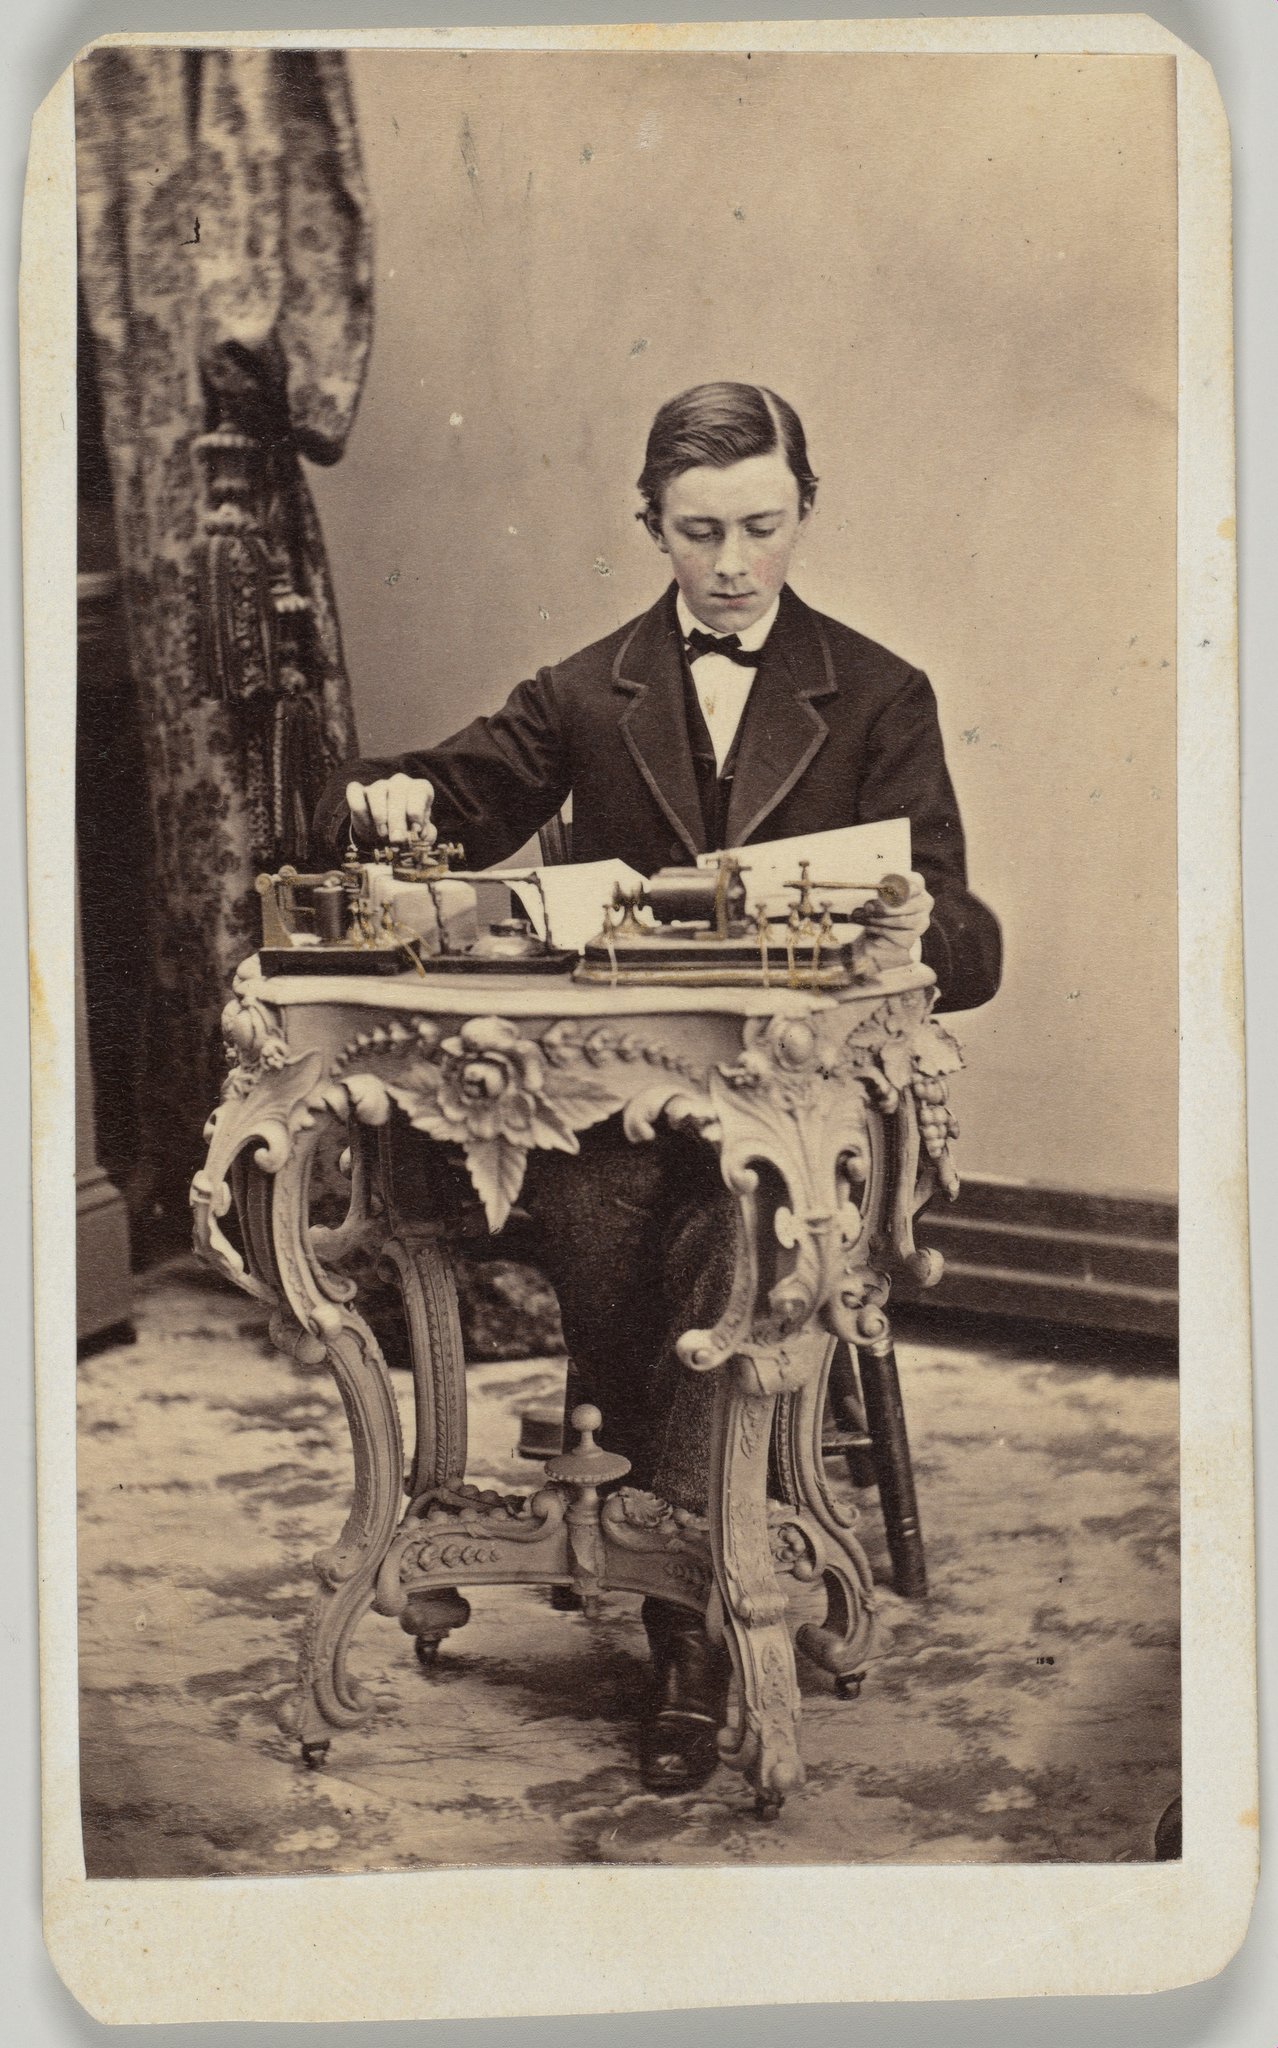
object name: photograph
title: [Telegrapher]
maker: e. webb's union gallery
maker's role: artist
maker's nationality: american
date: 1868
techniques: albumen silver print